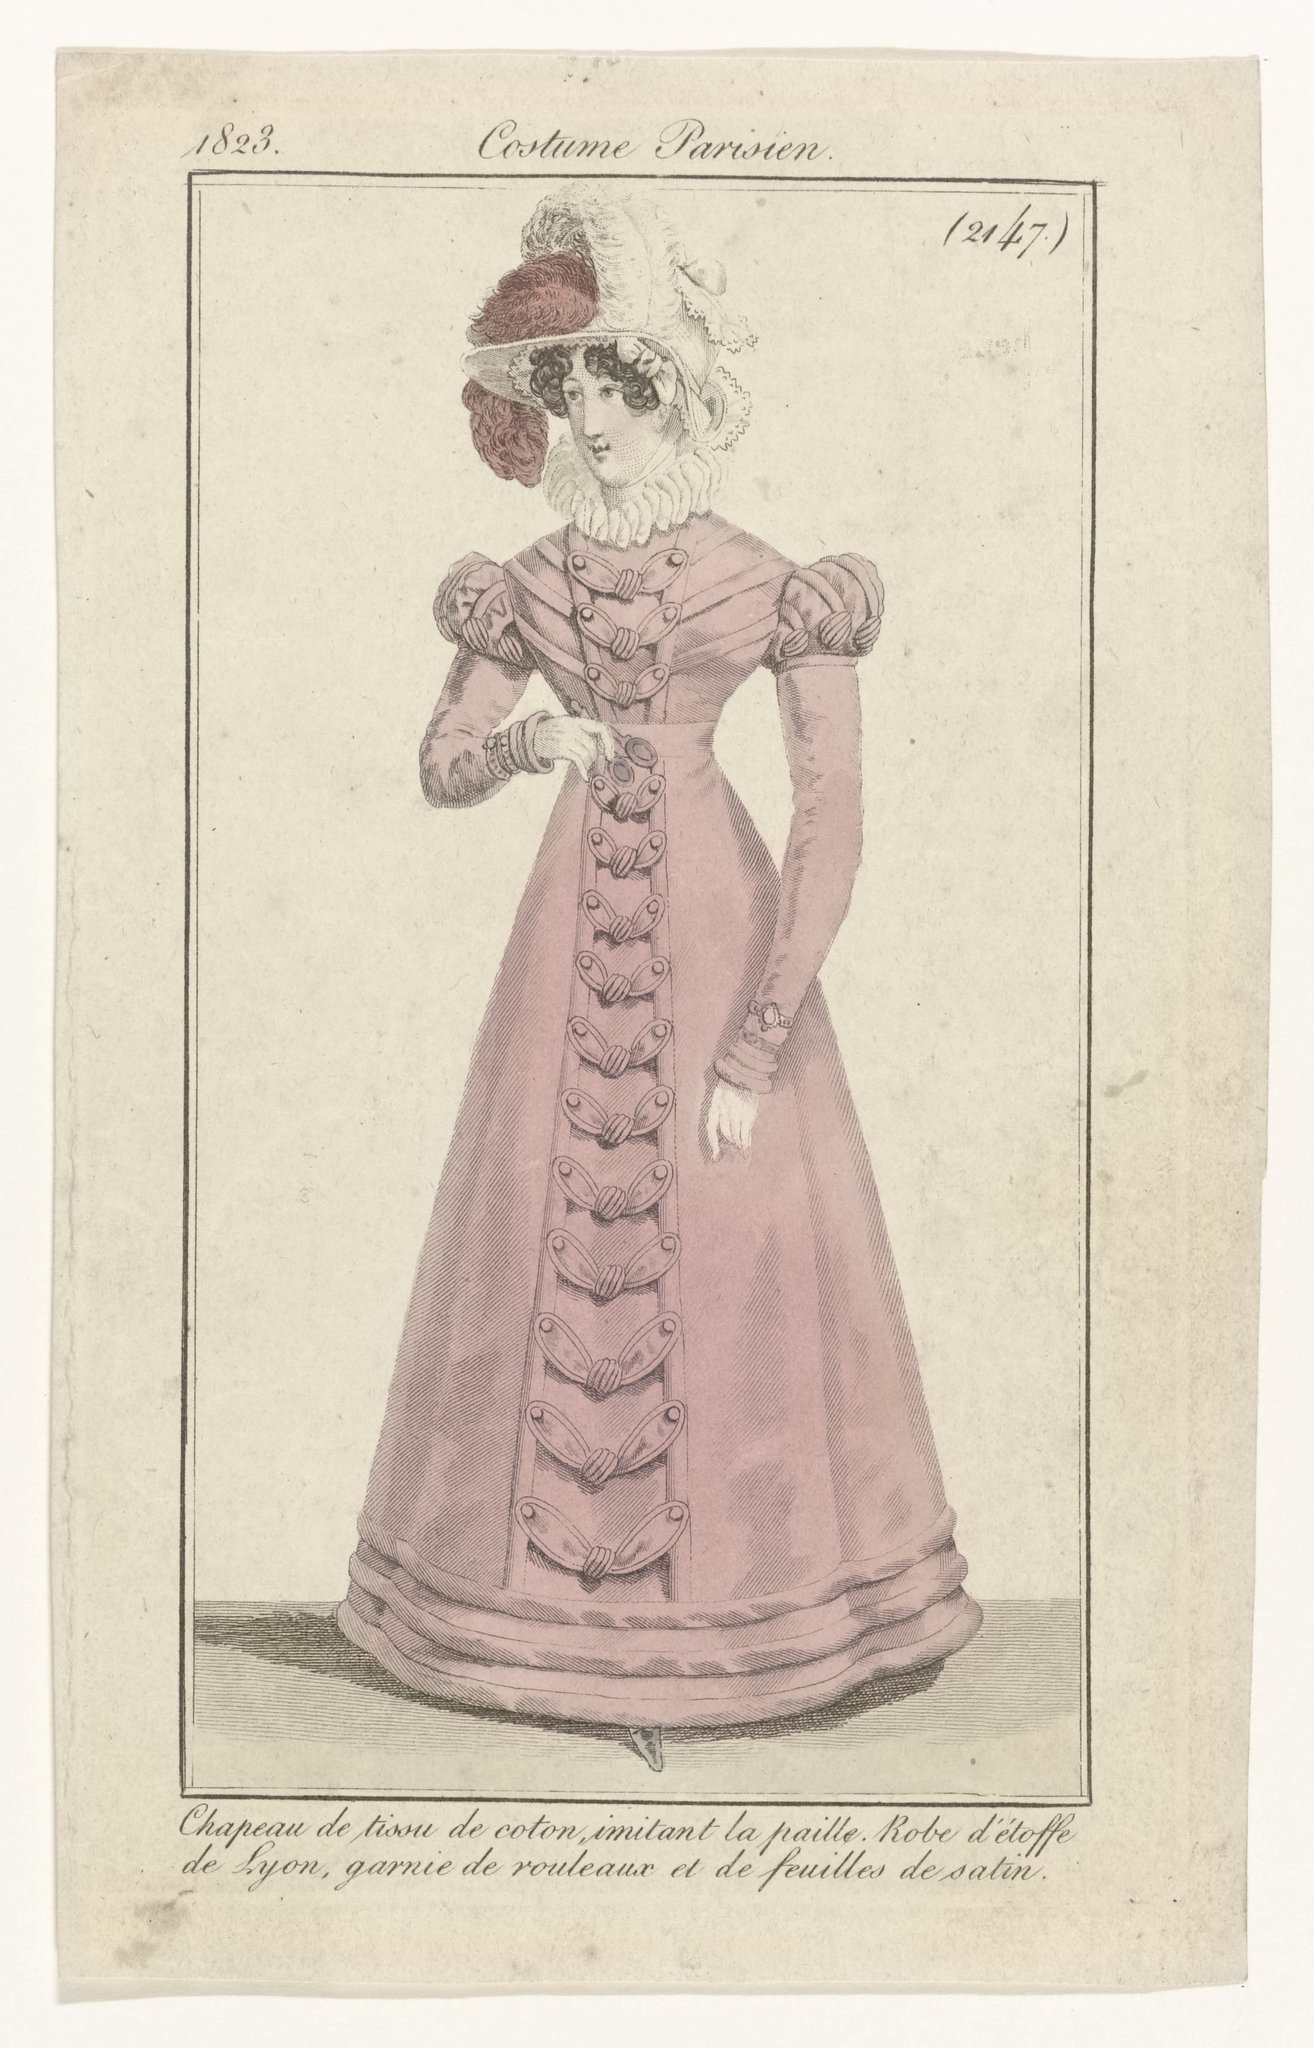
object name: fashion print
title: Journal des Dames et des Modes, Costumes Parisiens, 1823, (2147): Chapeau de tissu de coton (...)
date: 1823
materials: paper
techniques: engraving, hand coloring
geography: paris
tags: eyeglasses, spectacles, fashion plates, head-gear: hat (+ women's clothes), dress, gown (+ women's clothes)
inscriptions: title: ‘Costume Parisien.’, caption: ‘Chapeau de tissu de coton, imitant la paille. Robe d'étoffe de Lyon, garnie de rouleaux et de feuilles de satin.’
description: Staande vrouw gekleed in een japon van 'étoffe de Lyon' gegarneerd met een rouleaux en gebladerte van satijn. Op het hoofd een hoed van een katoenen stof, imitatie van stro. De prent maakt deel uit van het modetijdschrift Journal des Dames et des Modes, uitgegeven door Pierre de la Mésangère, Parijs, 1797-1839.